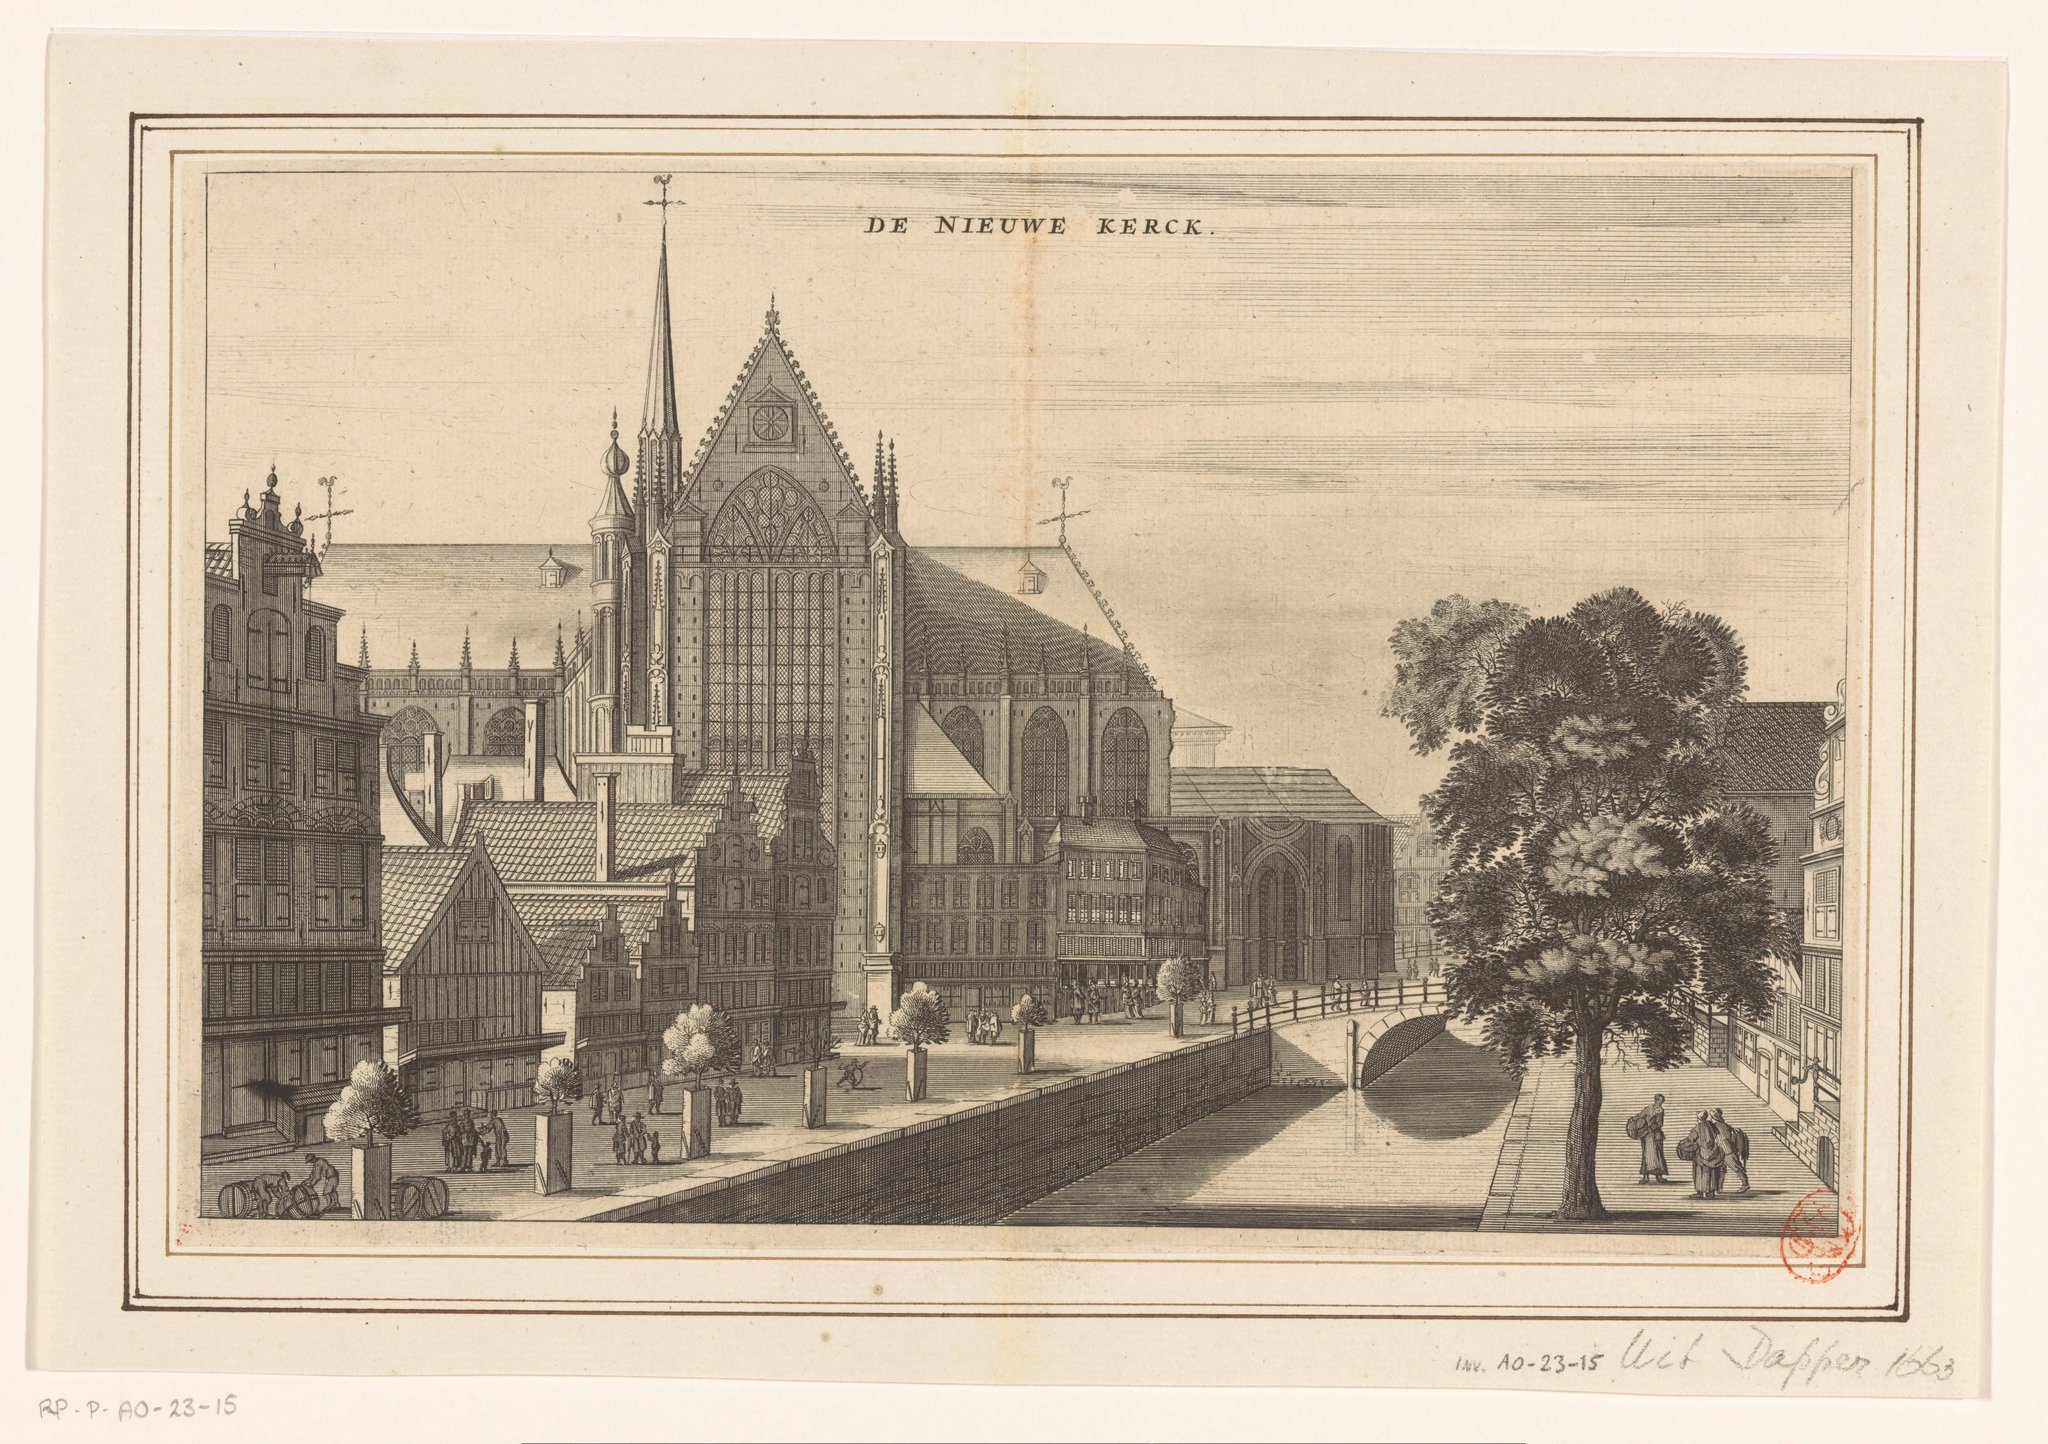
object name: print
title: De Nieuwe Kerck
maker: jacob van meurs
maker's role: draughtsman, print maker, publisher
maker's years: 1619-1680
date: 1663-1664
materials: paper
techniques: engraving, etching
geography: amsterdam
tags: bridge in city across river, canal, etc. (+ city(-scape) with figures, staffage), church (exterior), street (+ city(-scape) with figures, staffage)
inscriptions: collector's mark: Lugt 195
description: Huidige staat van prent ook gebruikt in: Dapper, Olfert. Historische beschryving der stadt Amsterdam: waer in de voornaemste geschiedenissen (na een kort verhael van gansch Hollant en d'omleggende dorpen (…). Amsterdam: Jacob van Meurs, 1663.* En in: Zesen, Philipp von. Beschreibung der Stadt Amsterdam: darinnen von derselben ersten Ursprunge bis auf gegenwärtigen Zustand (…). Amsterdam: Joachim Nosche, 1664. * In sommige exemplaren van deze uitgave komt de huidige staat van de prent voor. In andere exemplaren is een latere staat ingebonden, waarop boven de Nederlandse een Franse titel is toegevoegd.